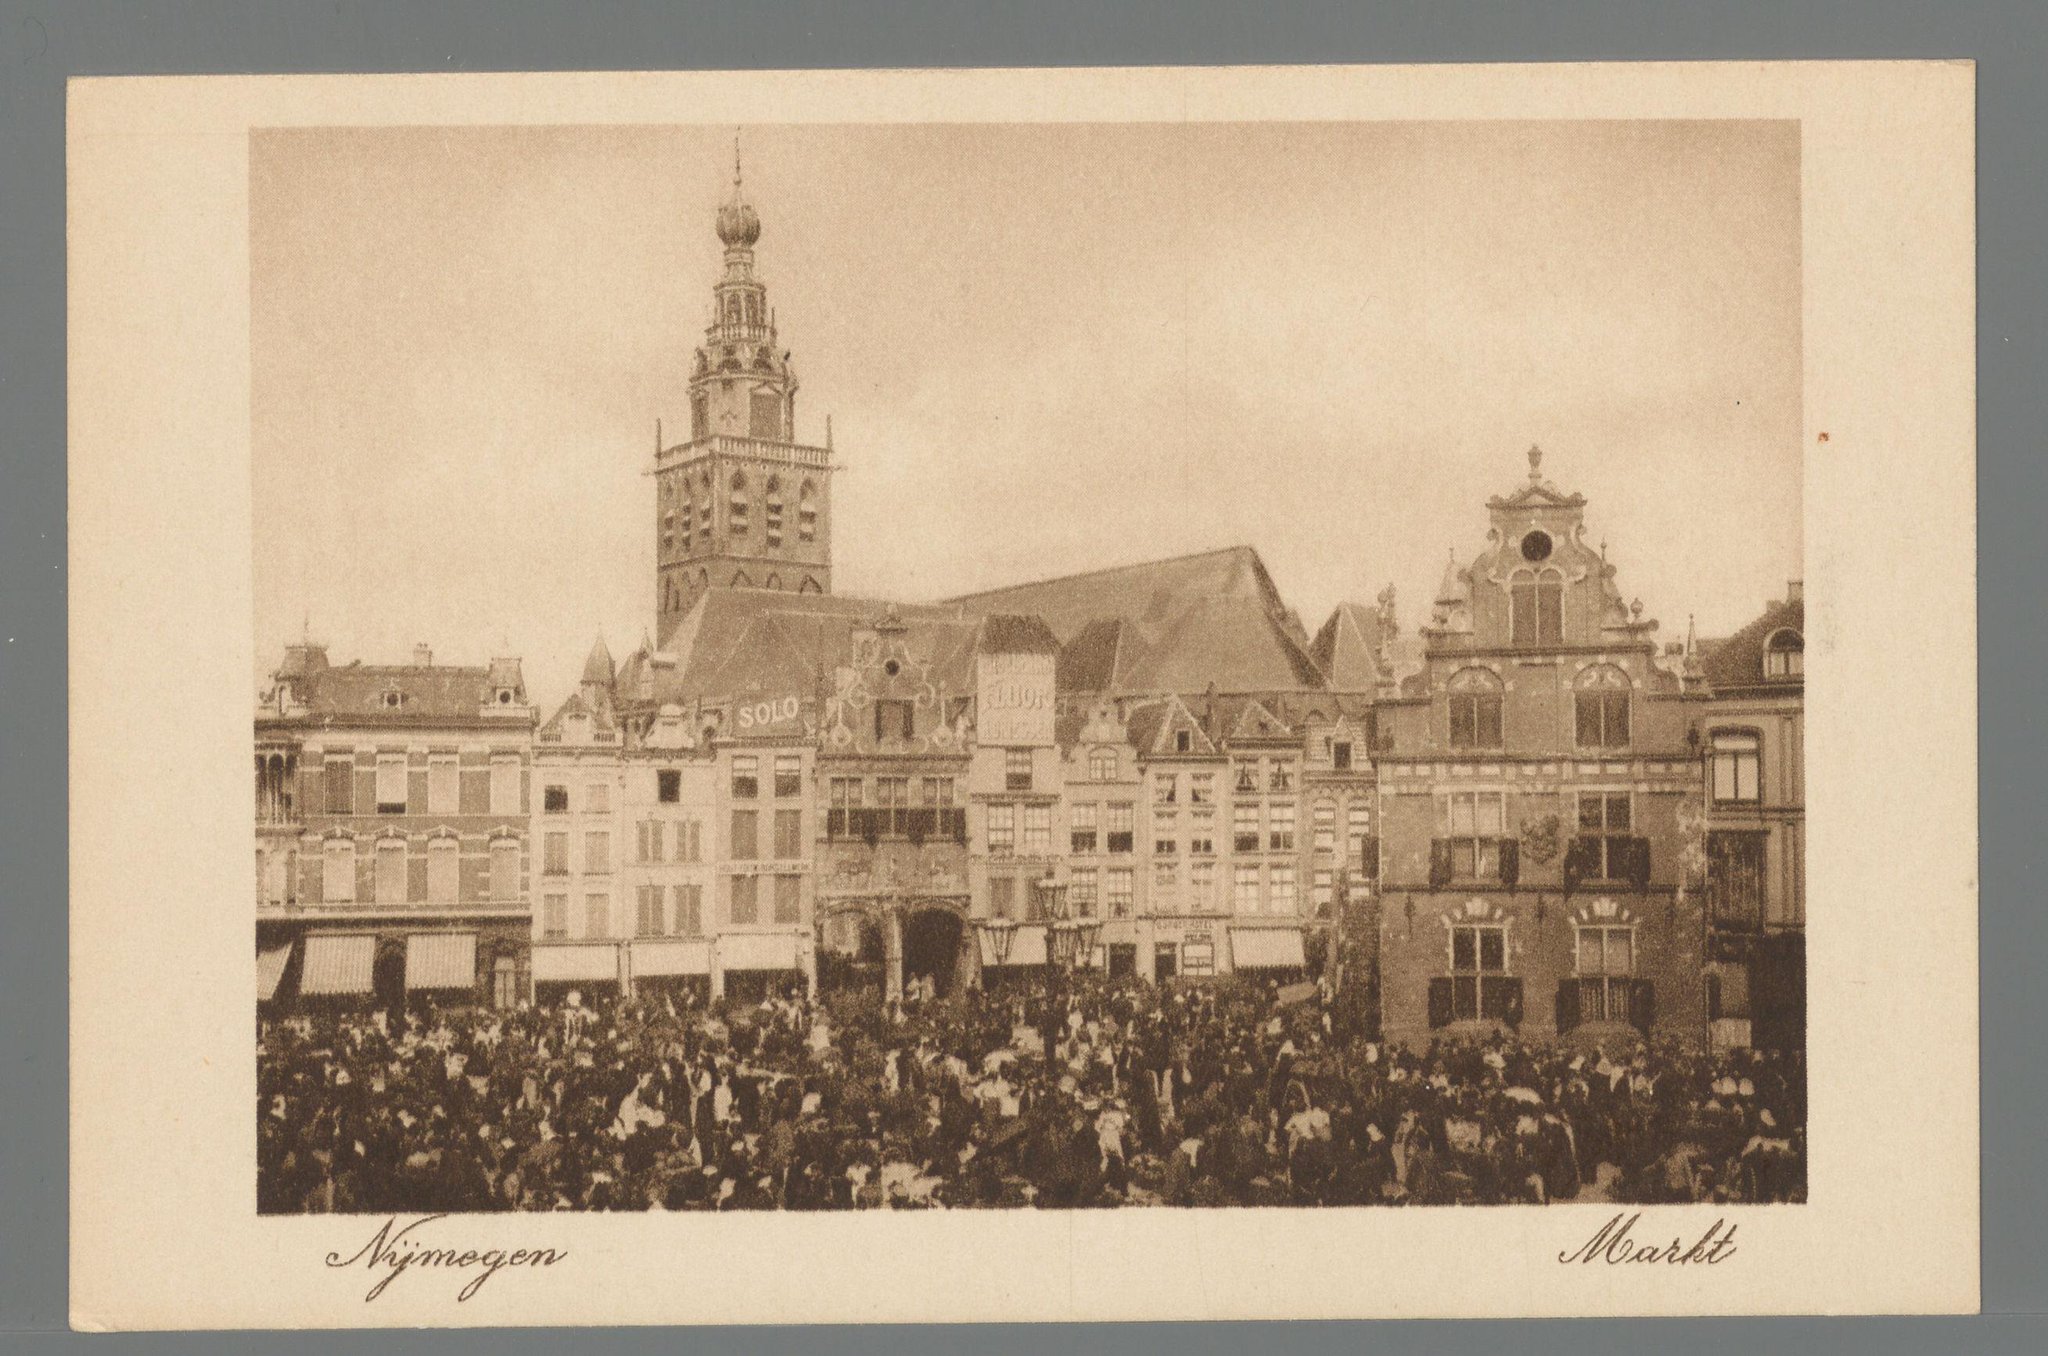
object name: photomechanical print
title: Nijmegen. Markt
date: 1913-1930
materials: cardboard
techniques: rotogravure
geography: rotterdam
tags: square, place, circus, etc., church (exterior), weigh-house